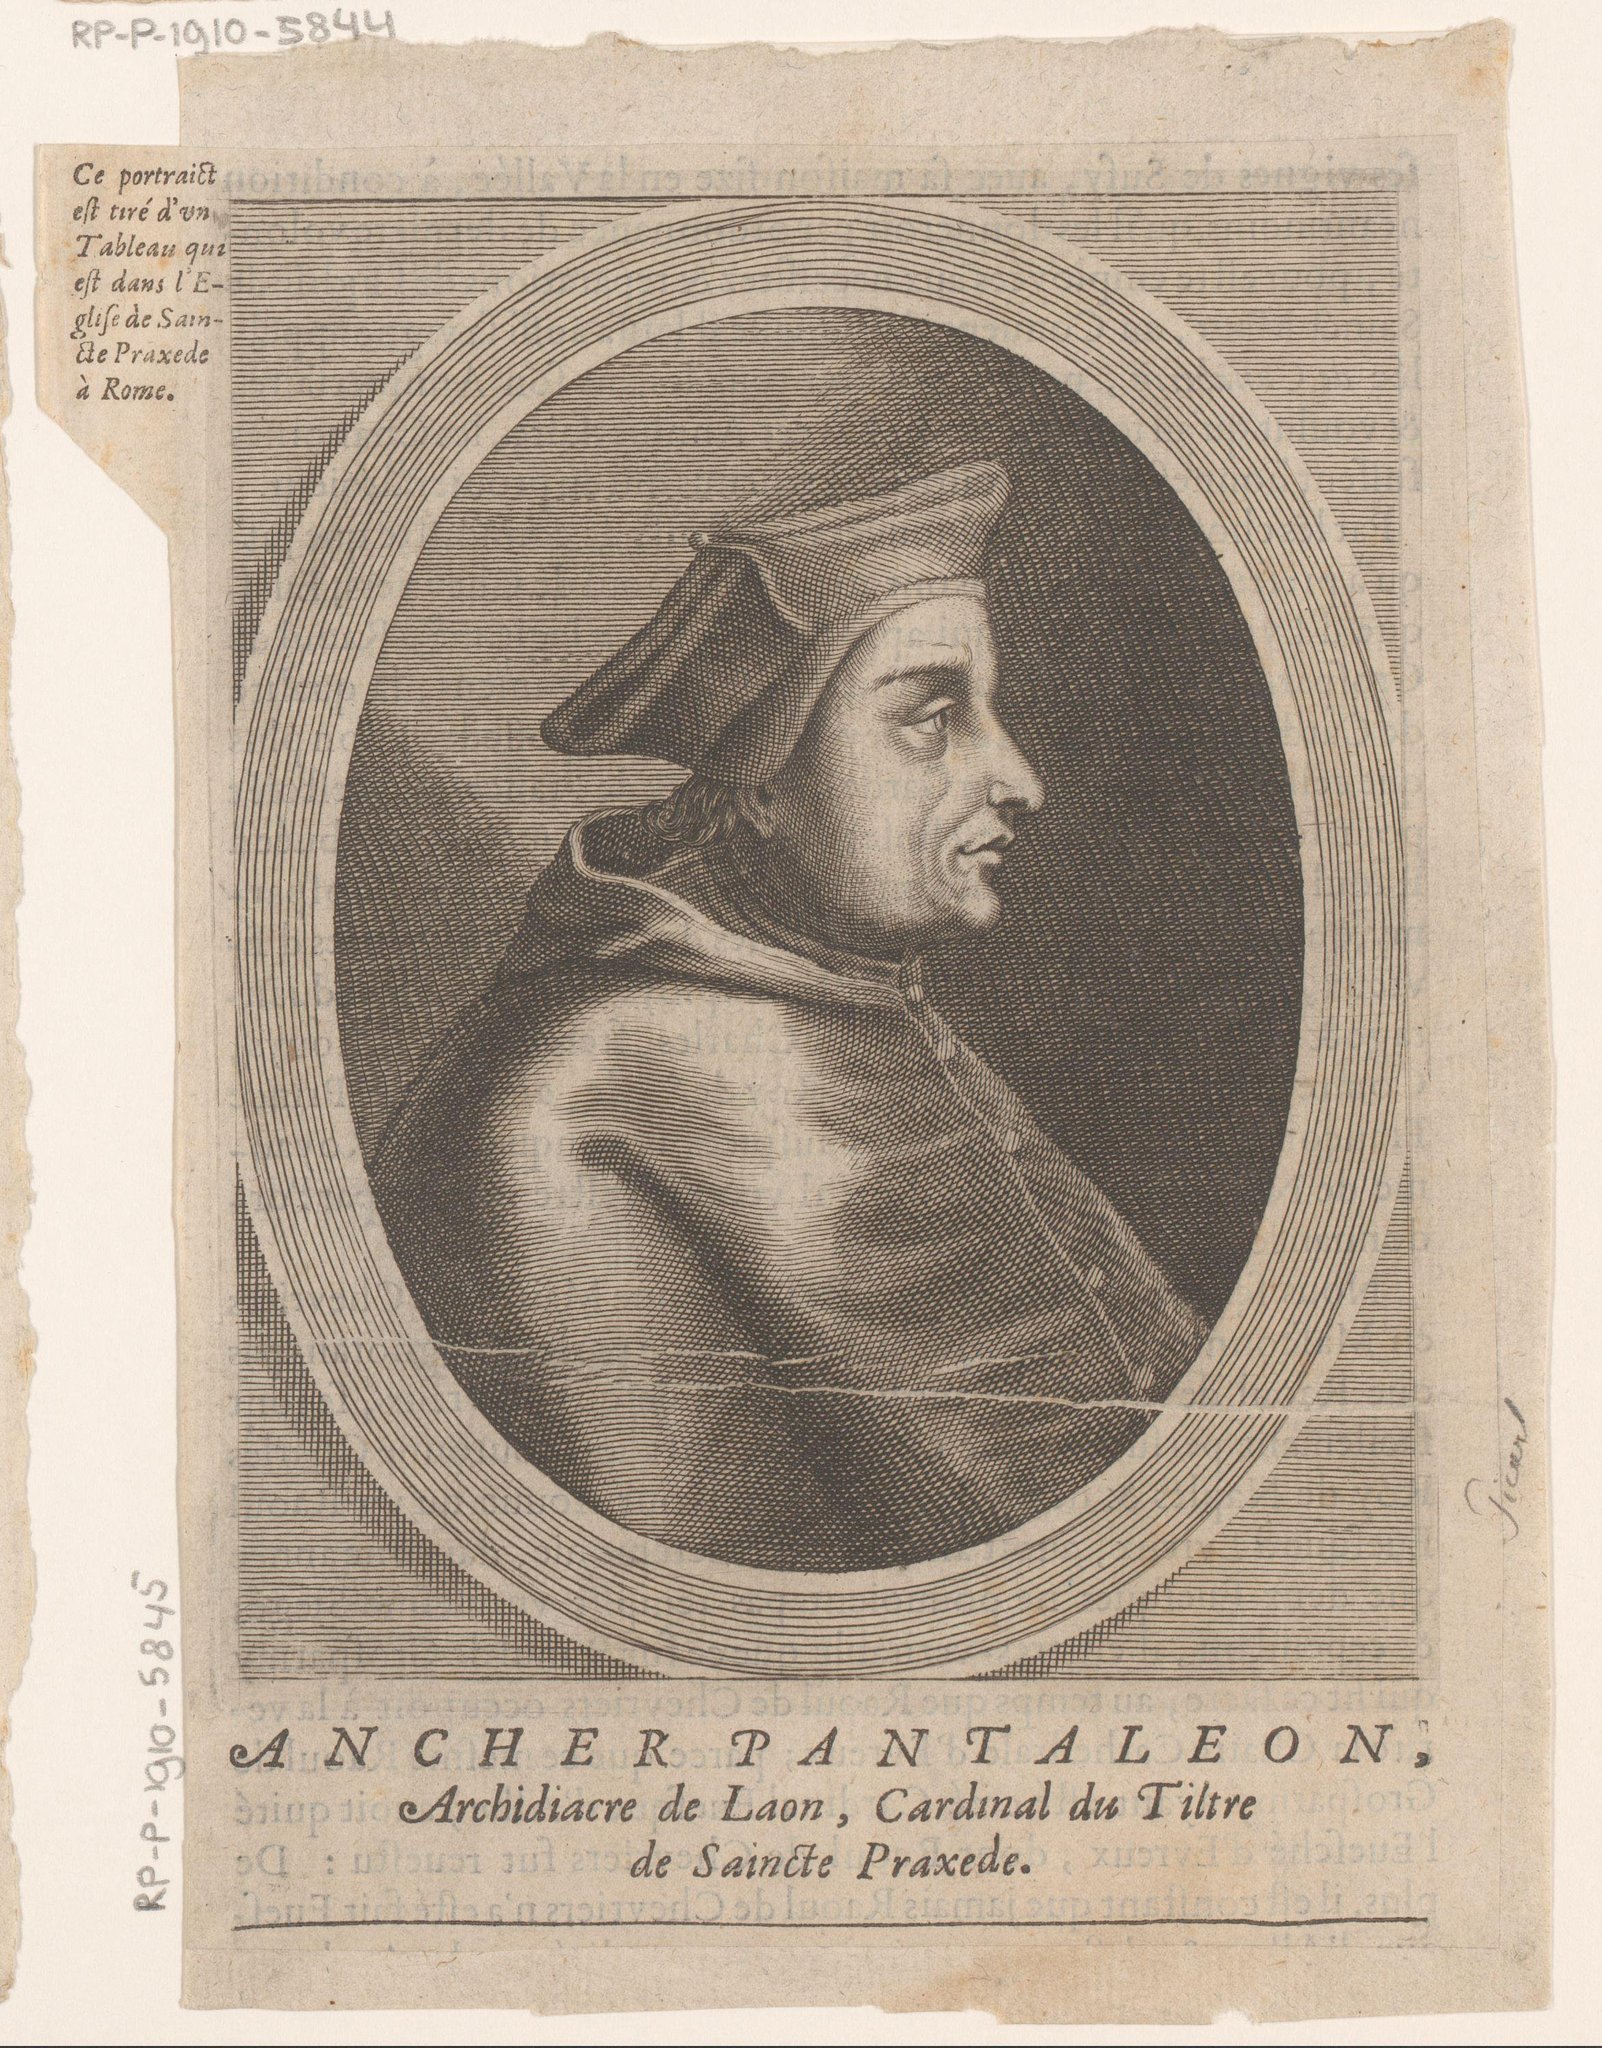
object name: book illustration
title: Ancher Pantaleon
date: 1660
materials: paper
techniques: engraving, etching, letterpress printing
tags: cardinal, historical persons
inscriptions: collector's mark: Lugt 2228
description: Prent uit: Du Chesne, François. Histoire de tous les cardinaux françois de naissance, ou qui ont esté promeus au cardinalat. Parijs: François Du Chesne, 1660.